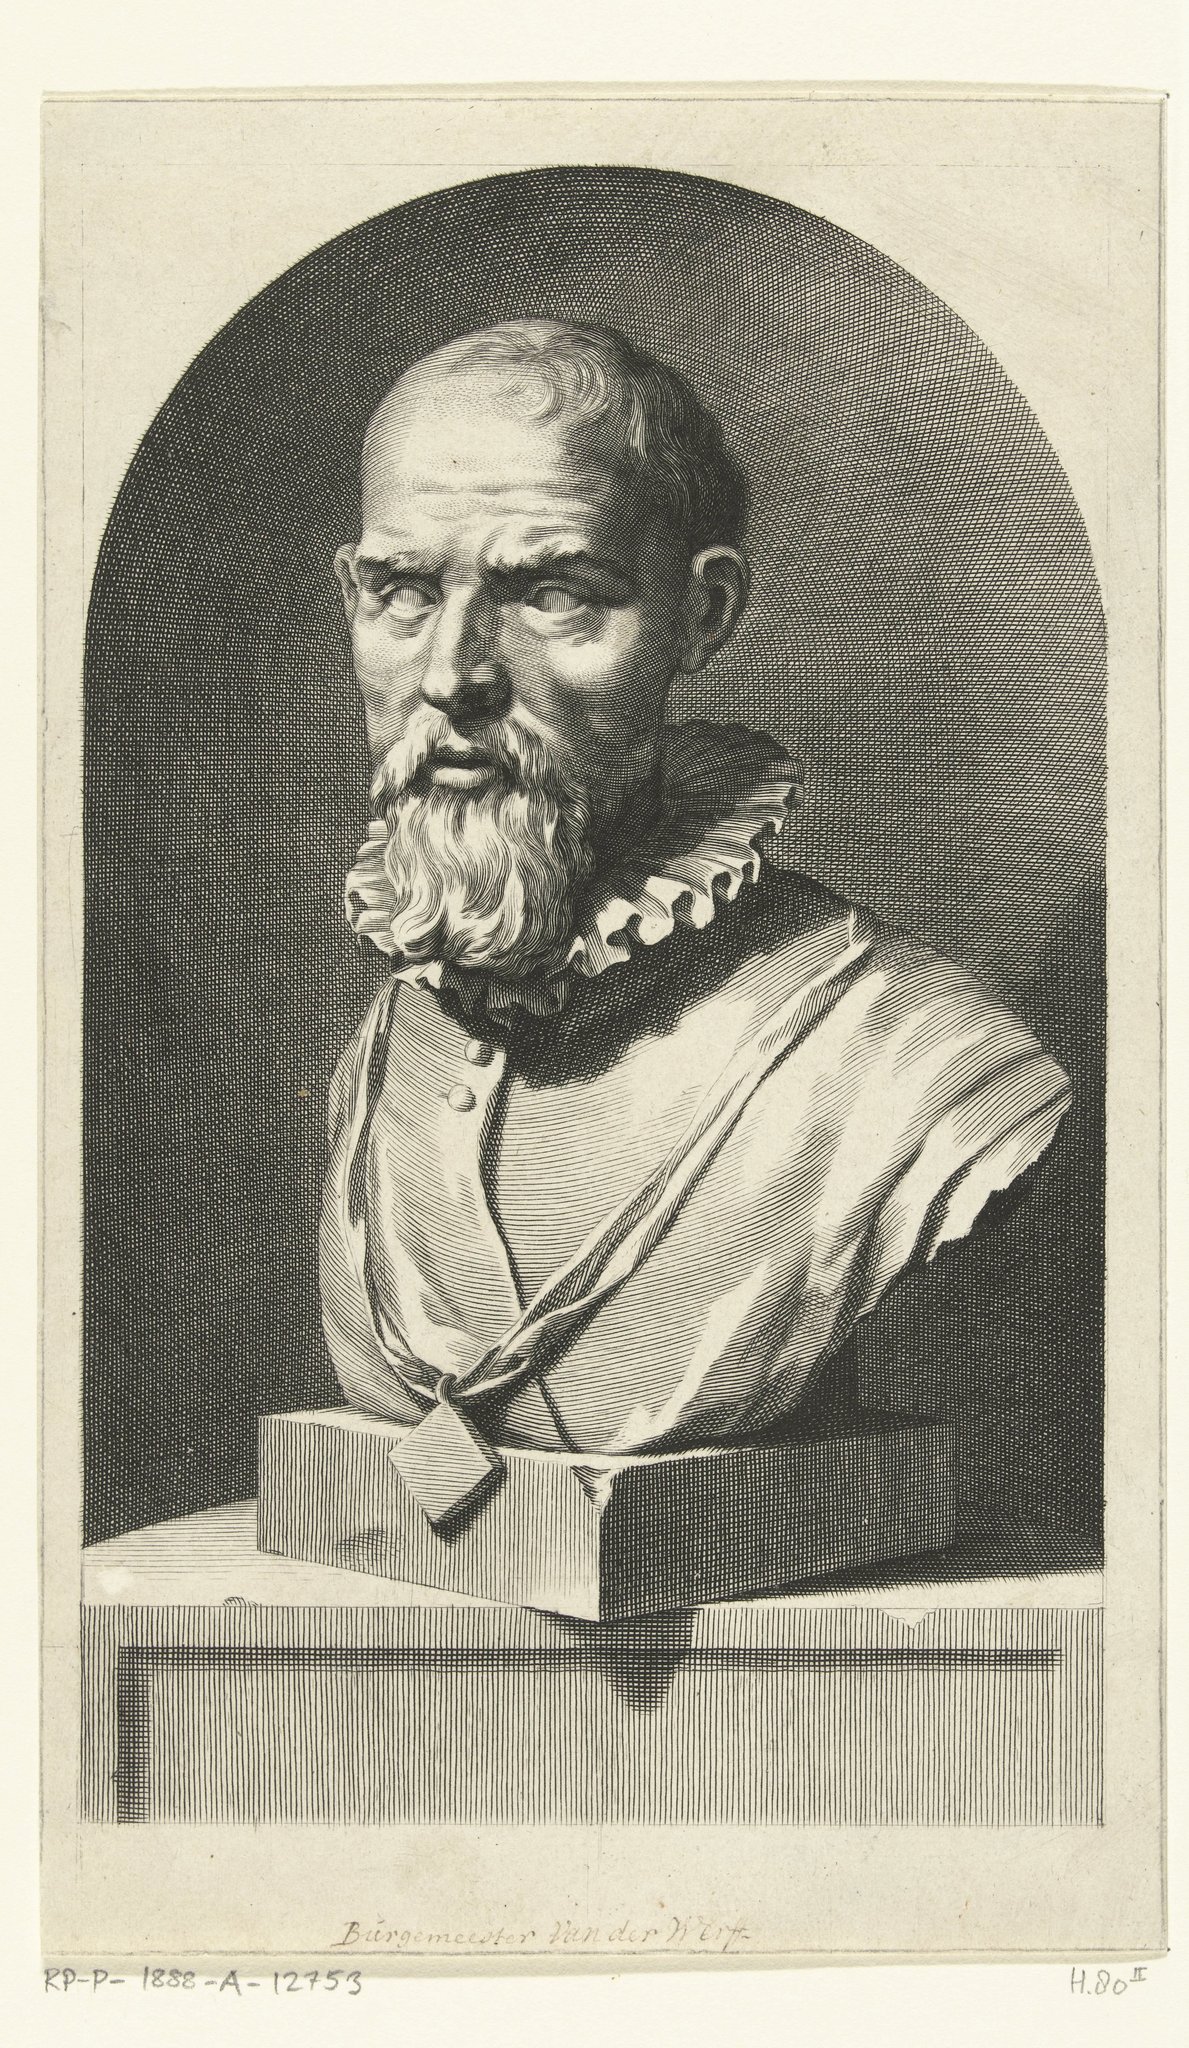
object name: print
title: Portretbuste van Pieter Adriaansz. van der Werff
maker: hendrik bary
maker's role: draughtsman, print maker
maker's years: 1640-1707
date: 1657-1707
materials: paper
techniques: engraving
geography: netherlands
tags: mayor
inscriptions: collector's mark: Lugt 2228, inscription: ‘Burgermeester van der Werff’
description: Afbeelding van een stenen portretbuste van Pieter Adriaansz. van der Werff.